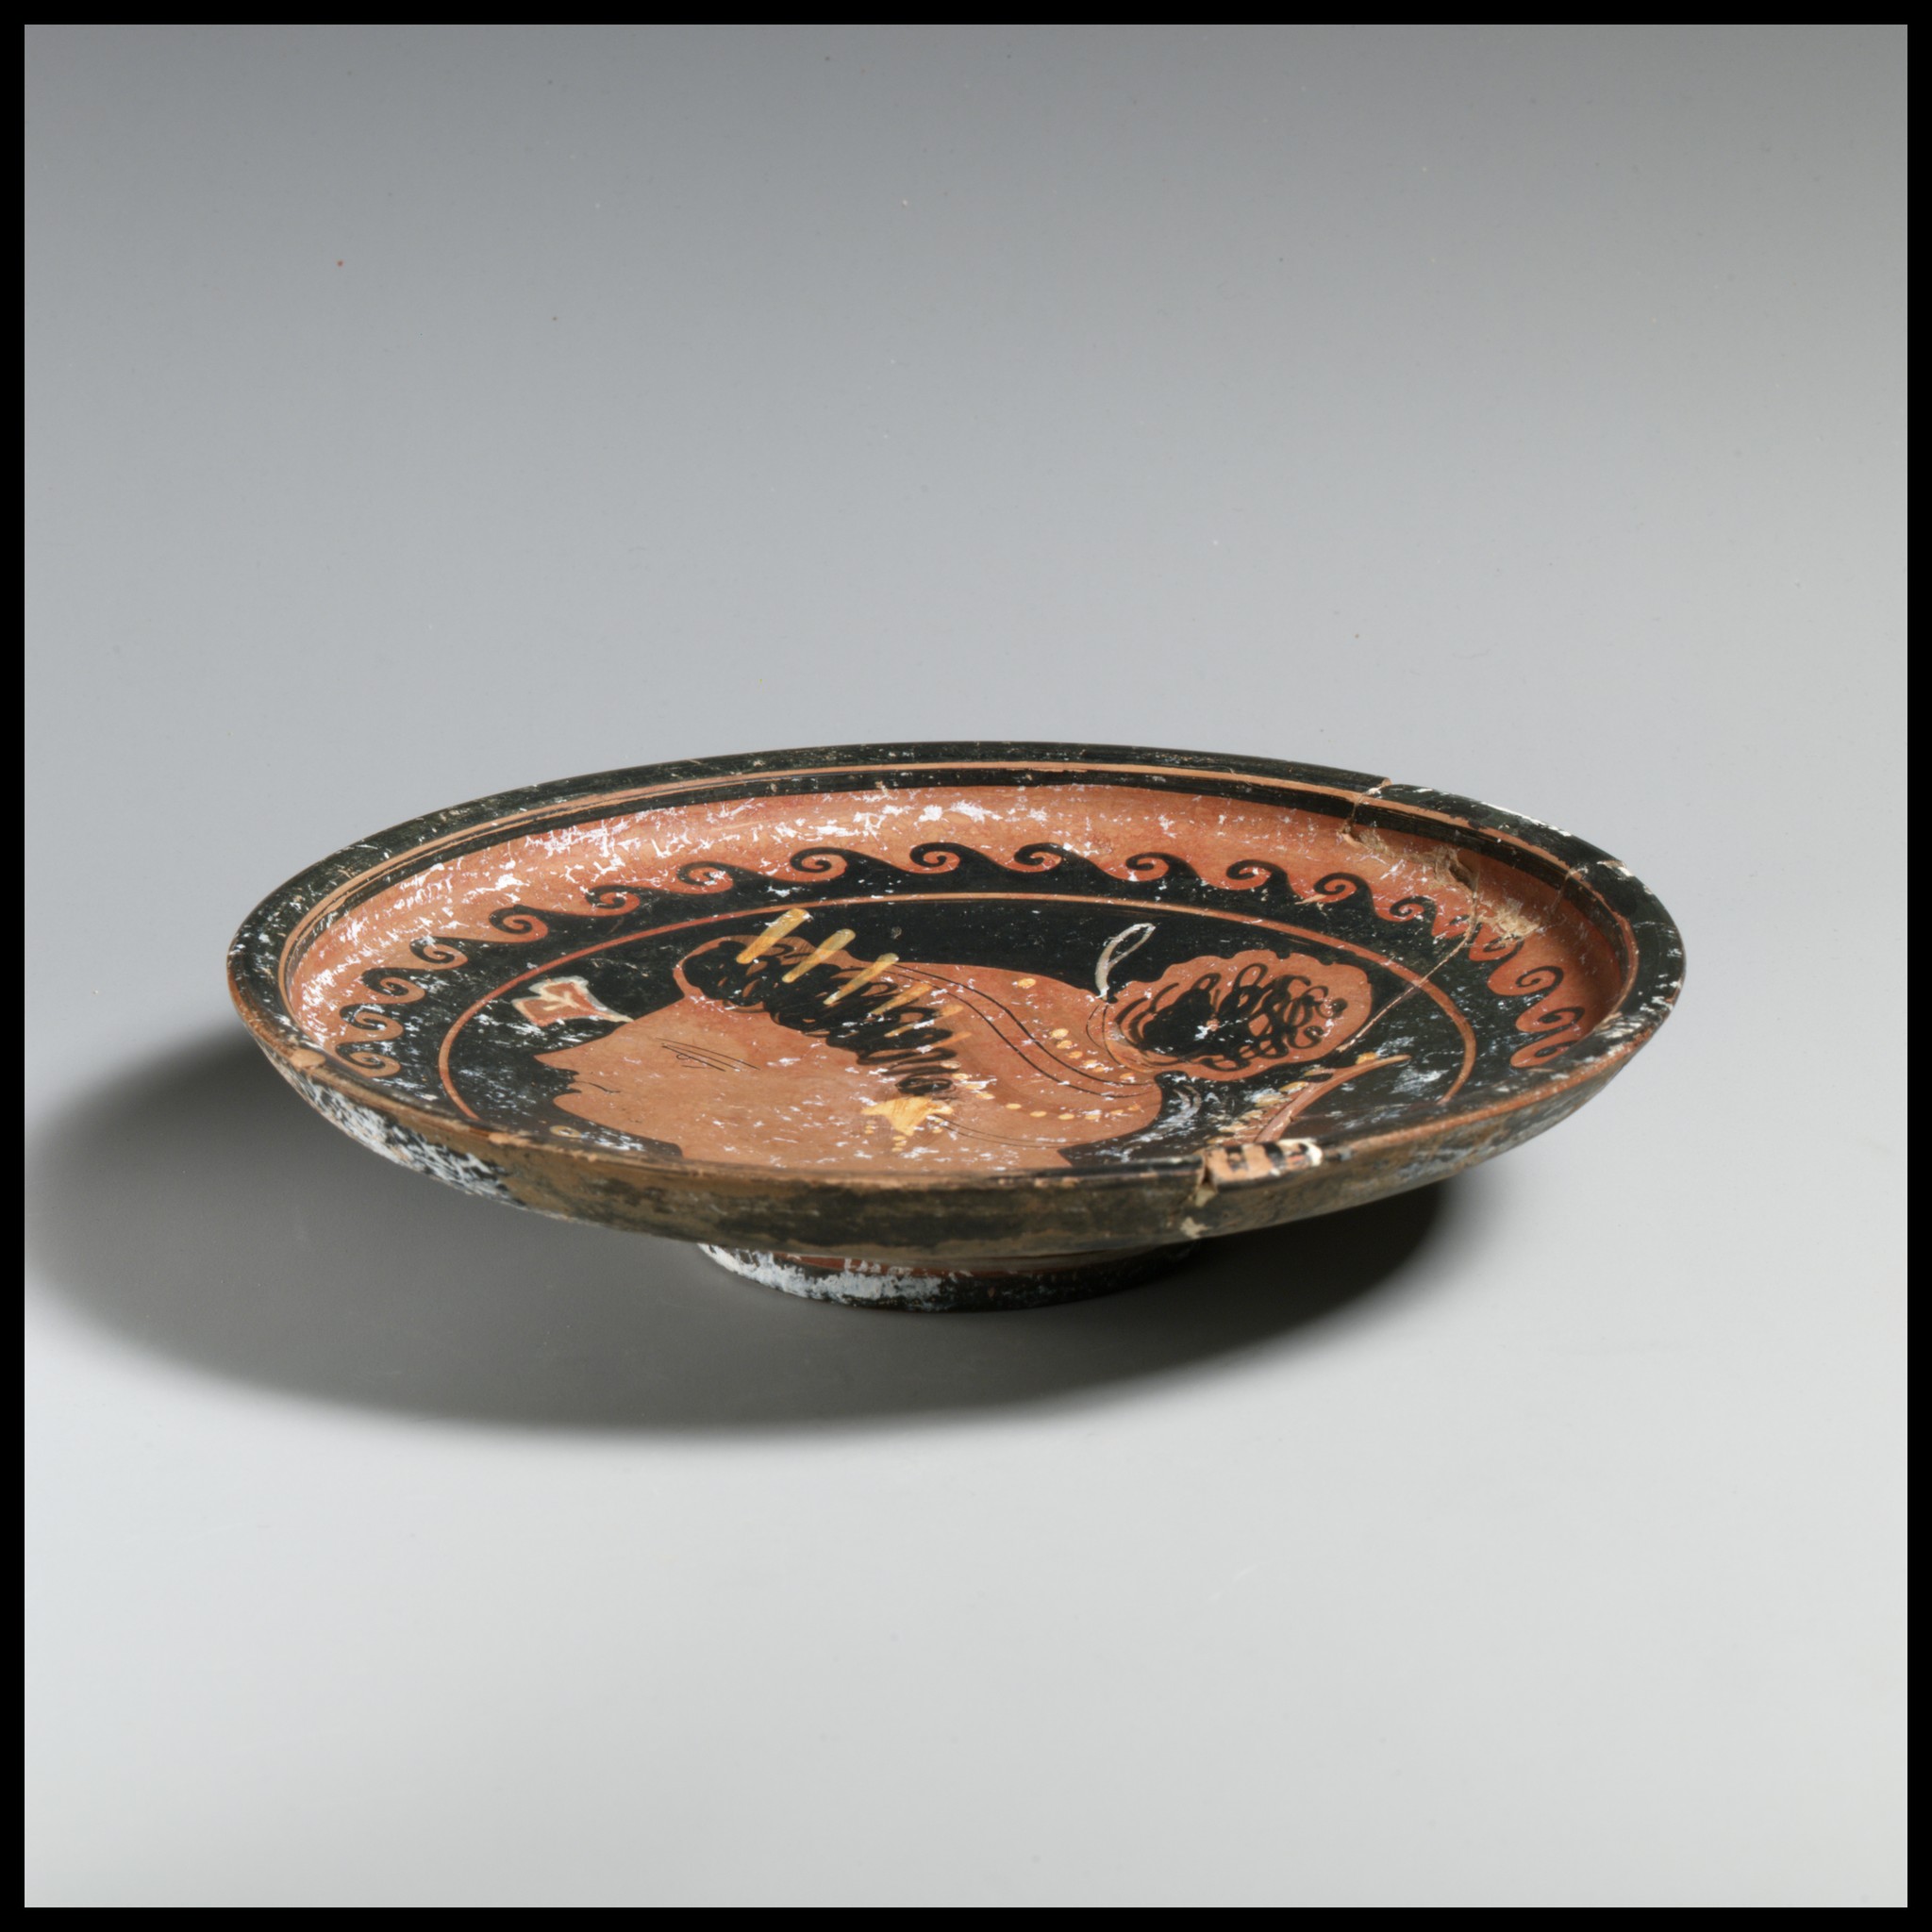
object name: plate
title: Terracotta plate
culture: greek, south italian, apulian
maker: painter of bari 1180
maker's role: artist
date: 350-325 BCE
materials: terracotta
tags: heads,women